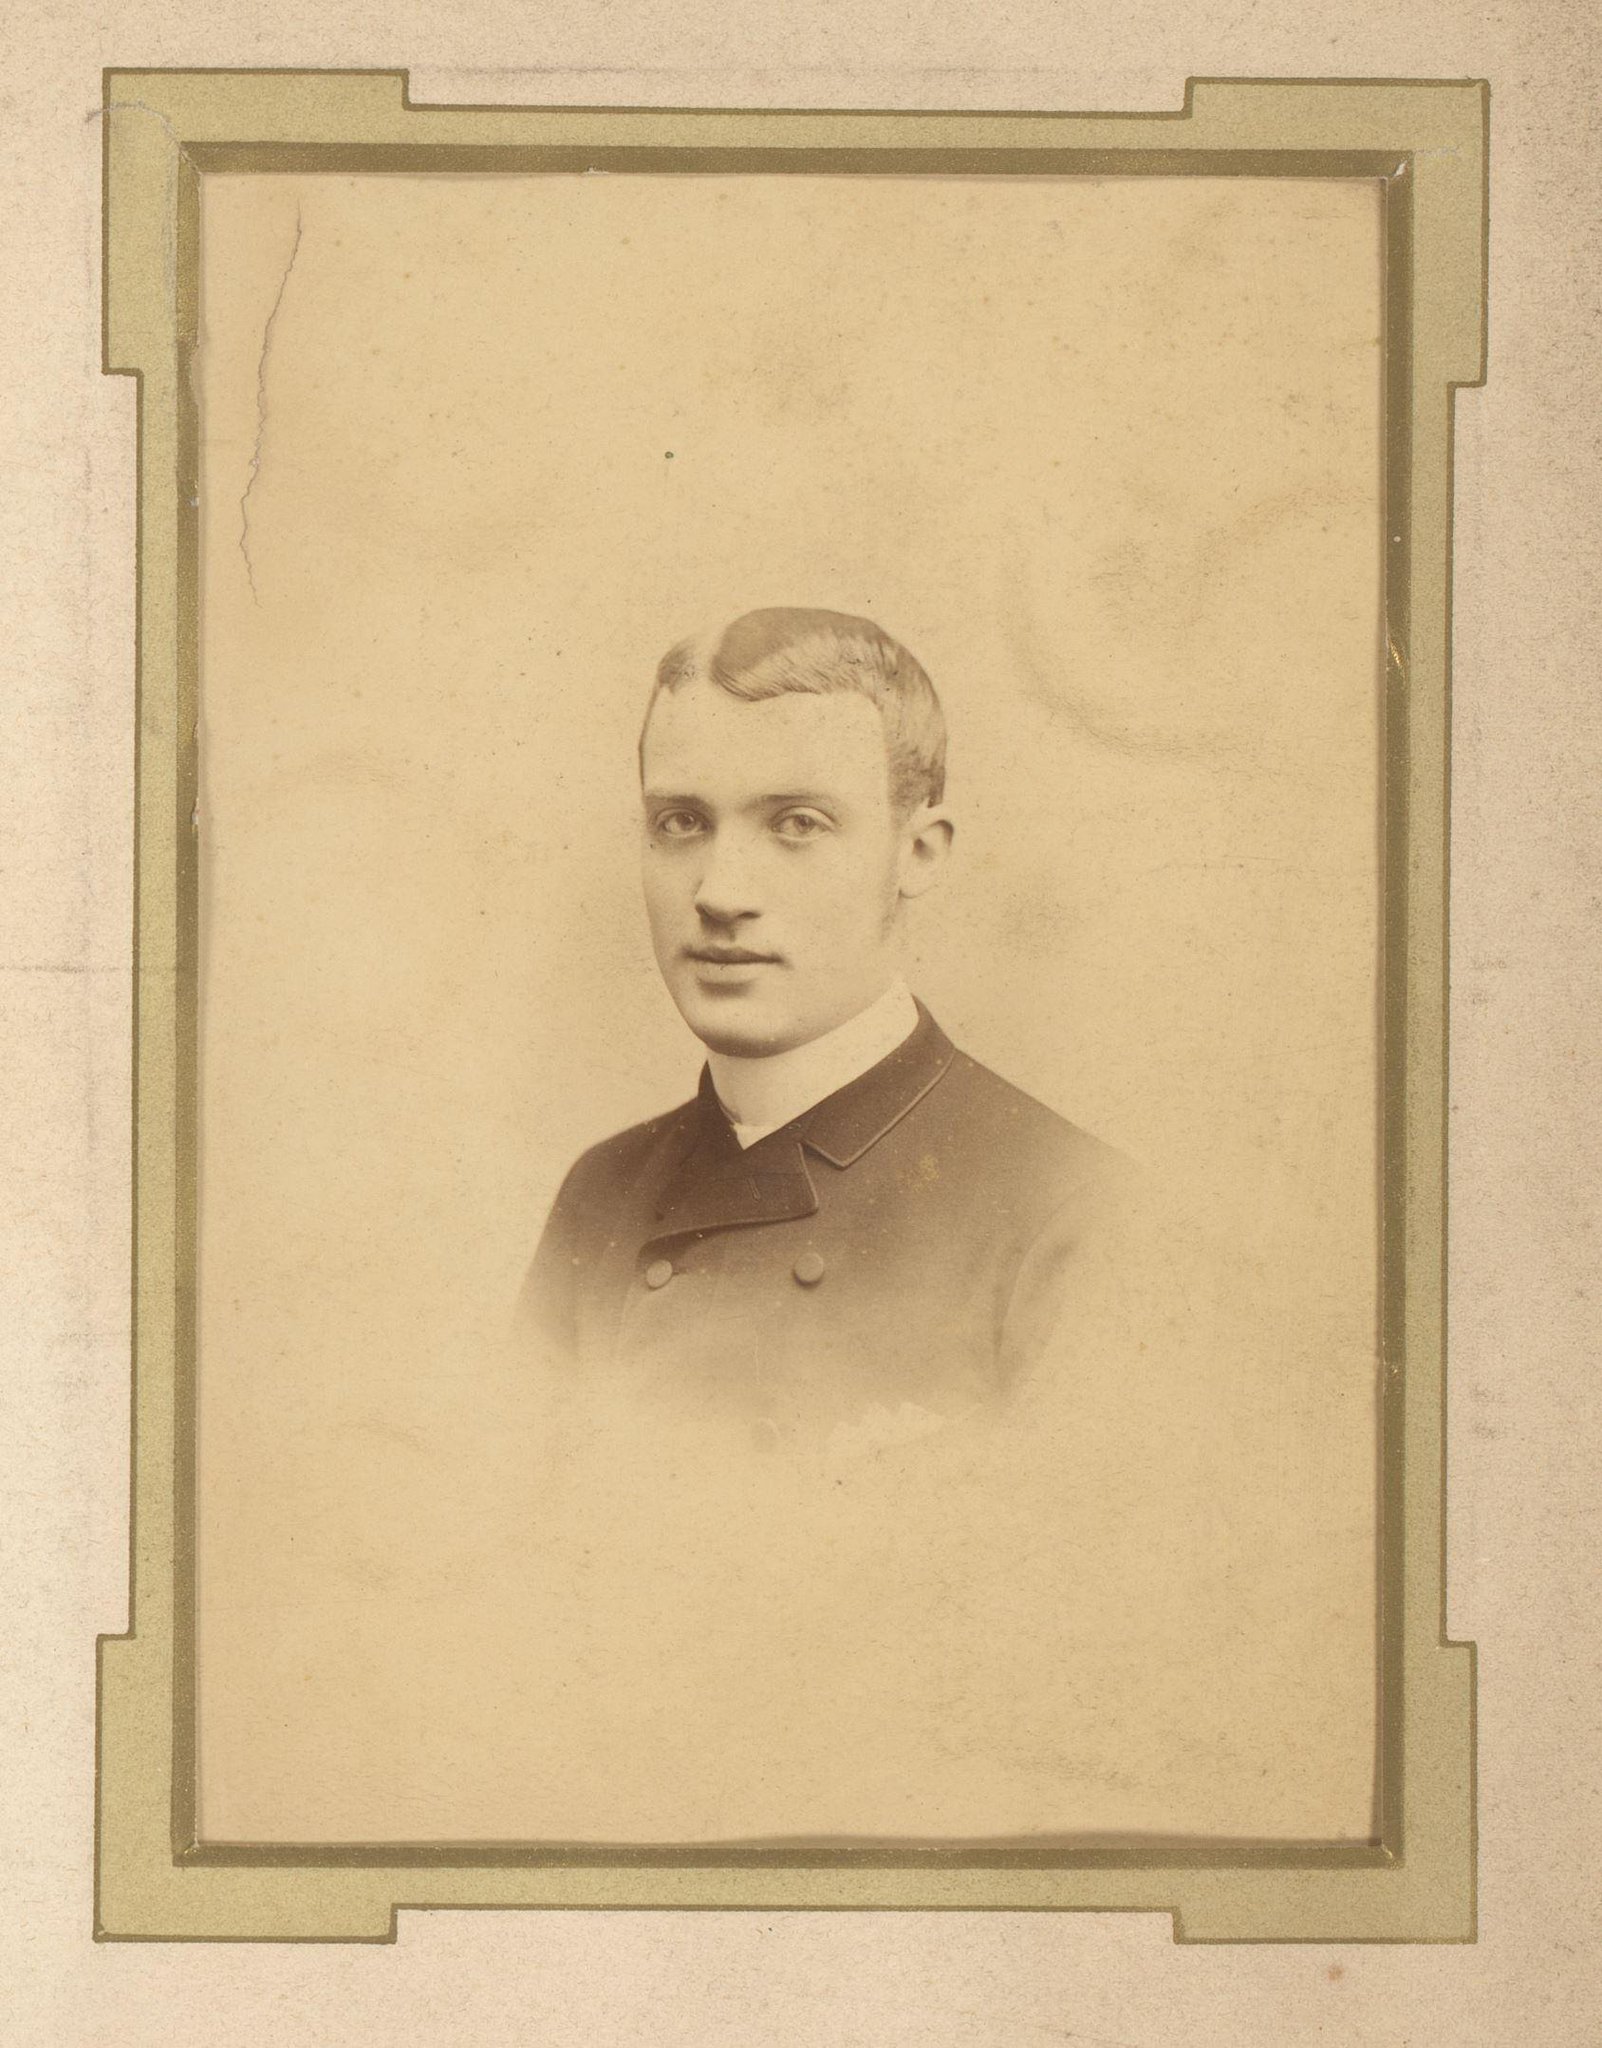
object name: album leaf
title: Portret van een man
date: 1878-1900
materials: cardboard, photographic support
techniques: albumen print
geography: paris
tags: historical persons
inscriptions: inscription: ‘Photographie d'Art/ Acard Fils/ 31, Boulevard Bonne Nouelle/ Paris’